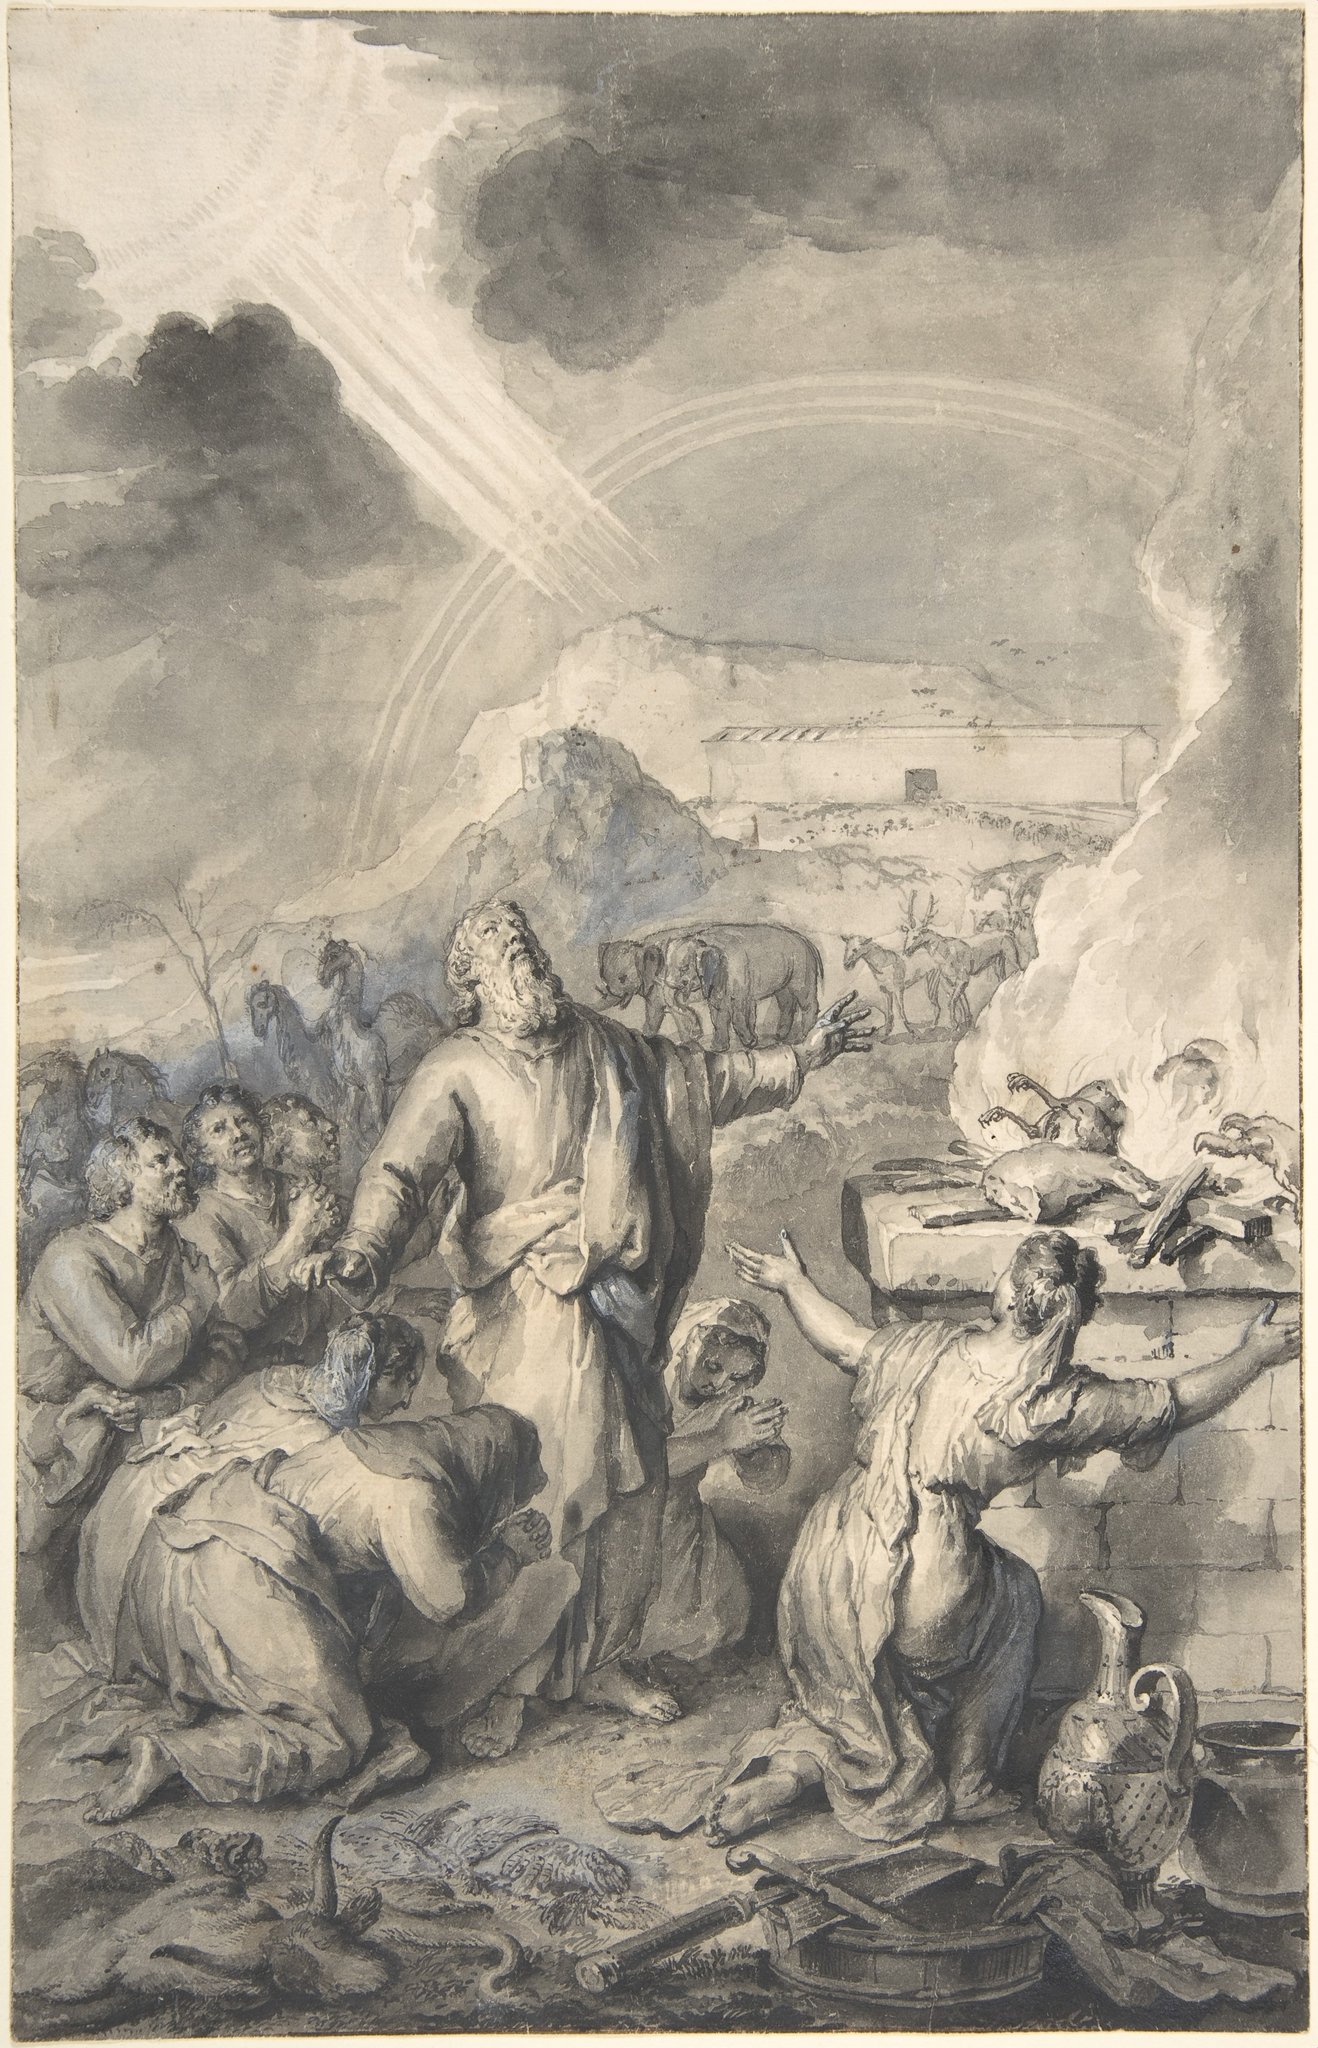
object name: drawing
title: The Sacrifice of Noah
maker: gerard hoet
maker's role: artist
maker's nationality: dutch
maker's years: 1648-1733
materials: ink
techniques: brush, pen, wash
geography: netherlands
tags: animals,men,women,mountains